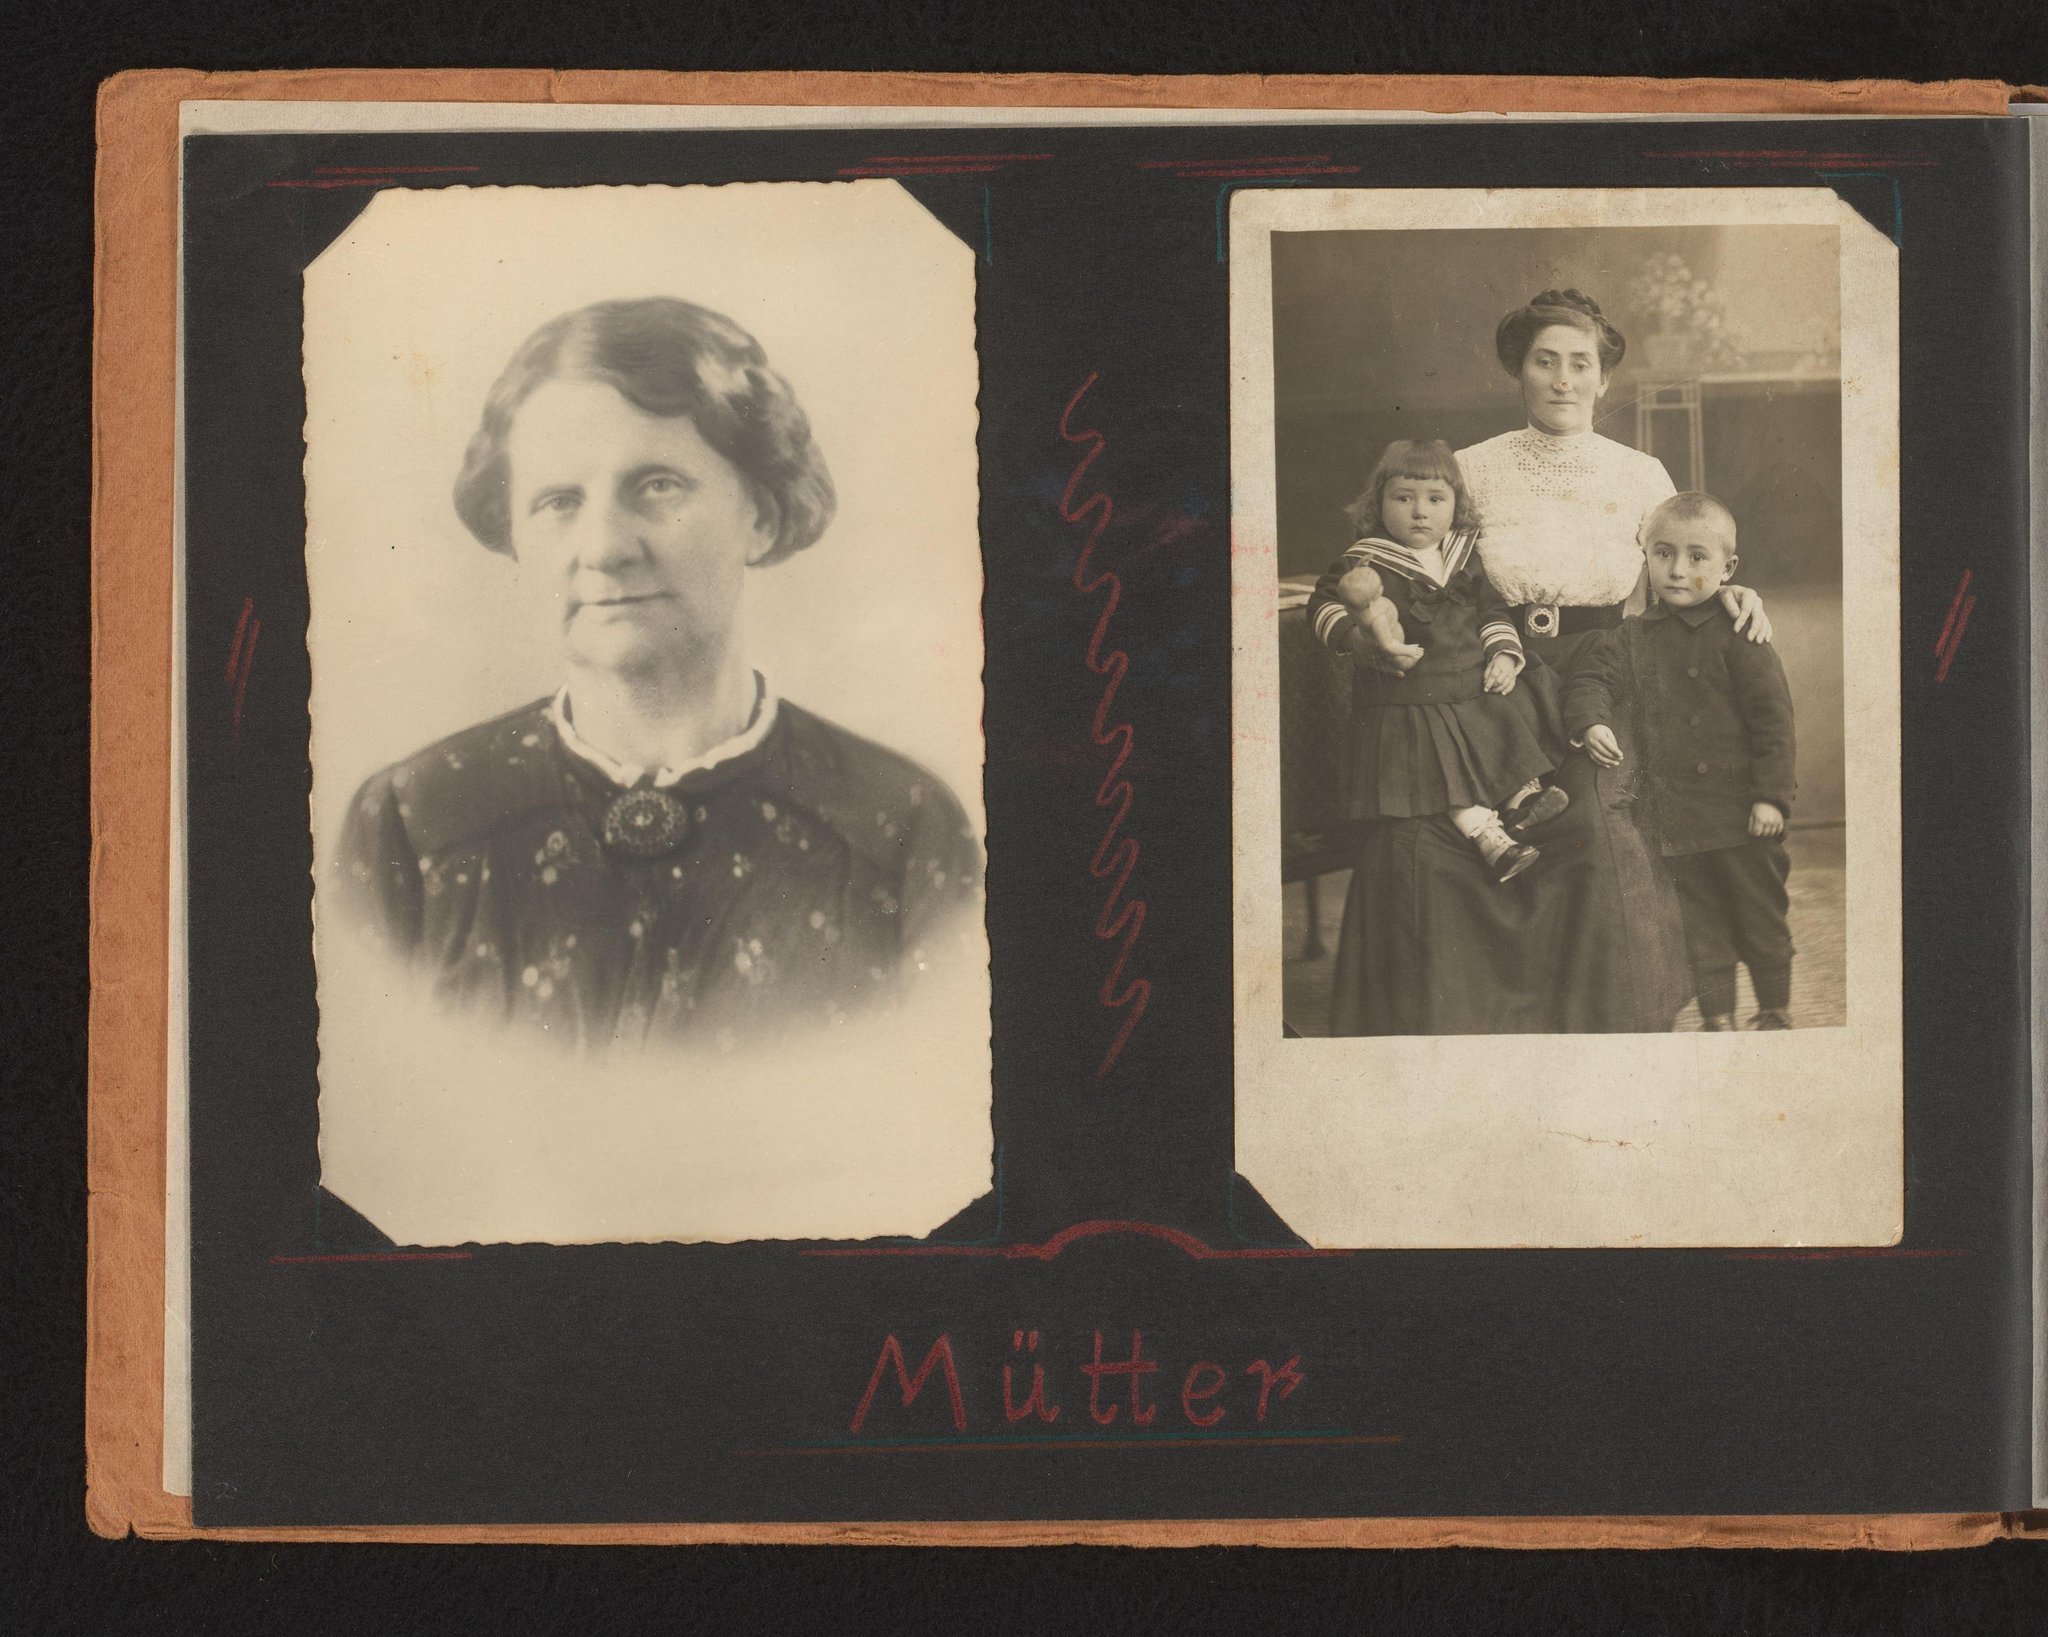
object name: album leaf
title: Mütter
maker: Anonymous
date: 1900-1930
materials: paper, pencil, photographic support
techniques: writing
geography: germany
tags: werner neufang, historical persons not known by name - bb - woman, historical persons, germany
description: Albumblad met twee foto's van de familie van Werner Neufang. Onderdeel van een fotoalbum over de Duitse Werner Neufang van de Kriegsmarine en de Nederlandse Thea Driesen.